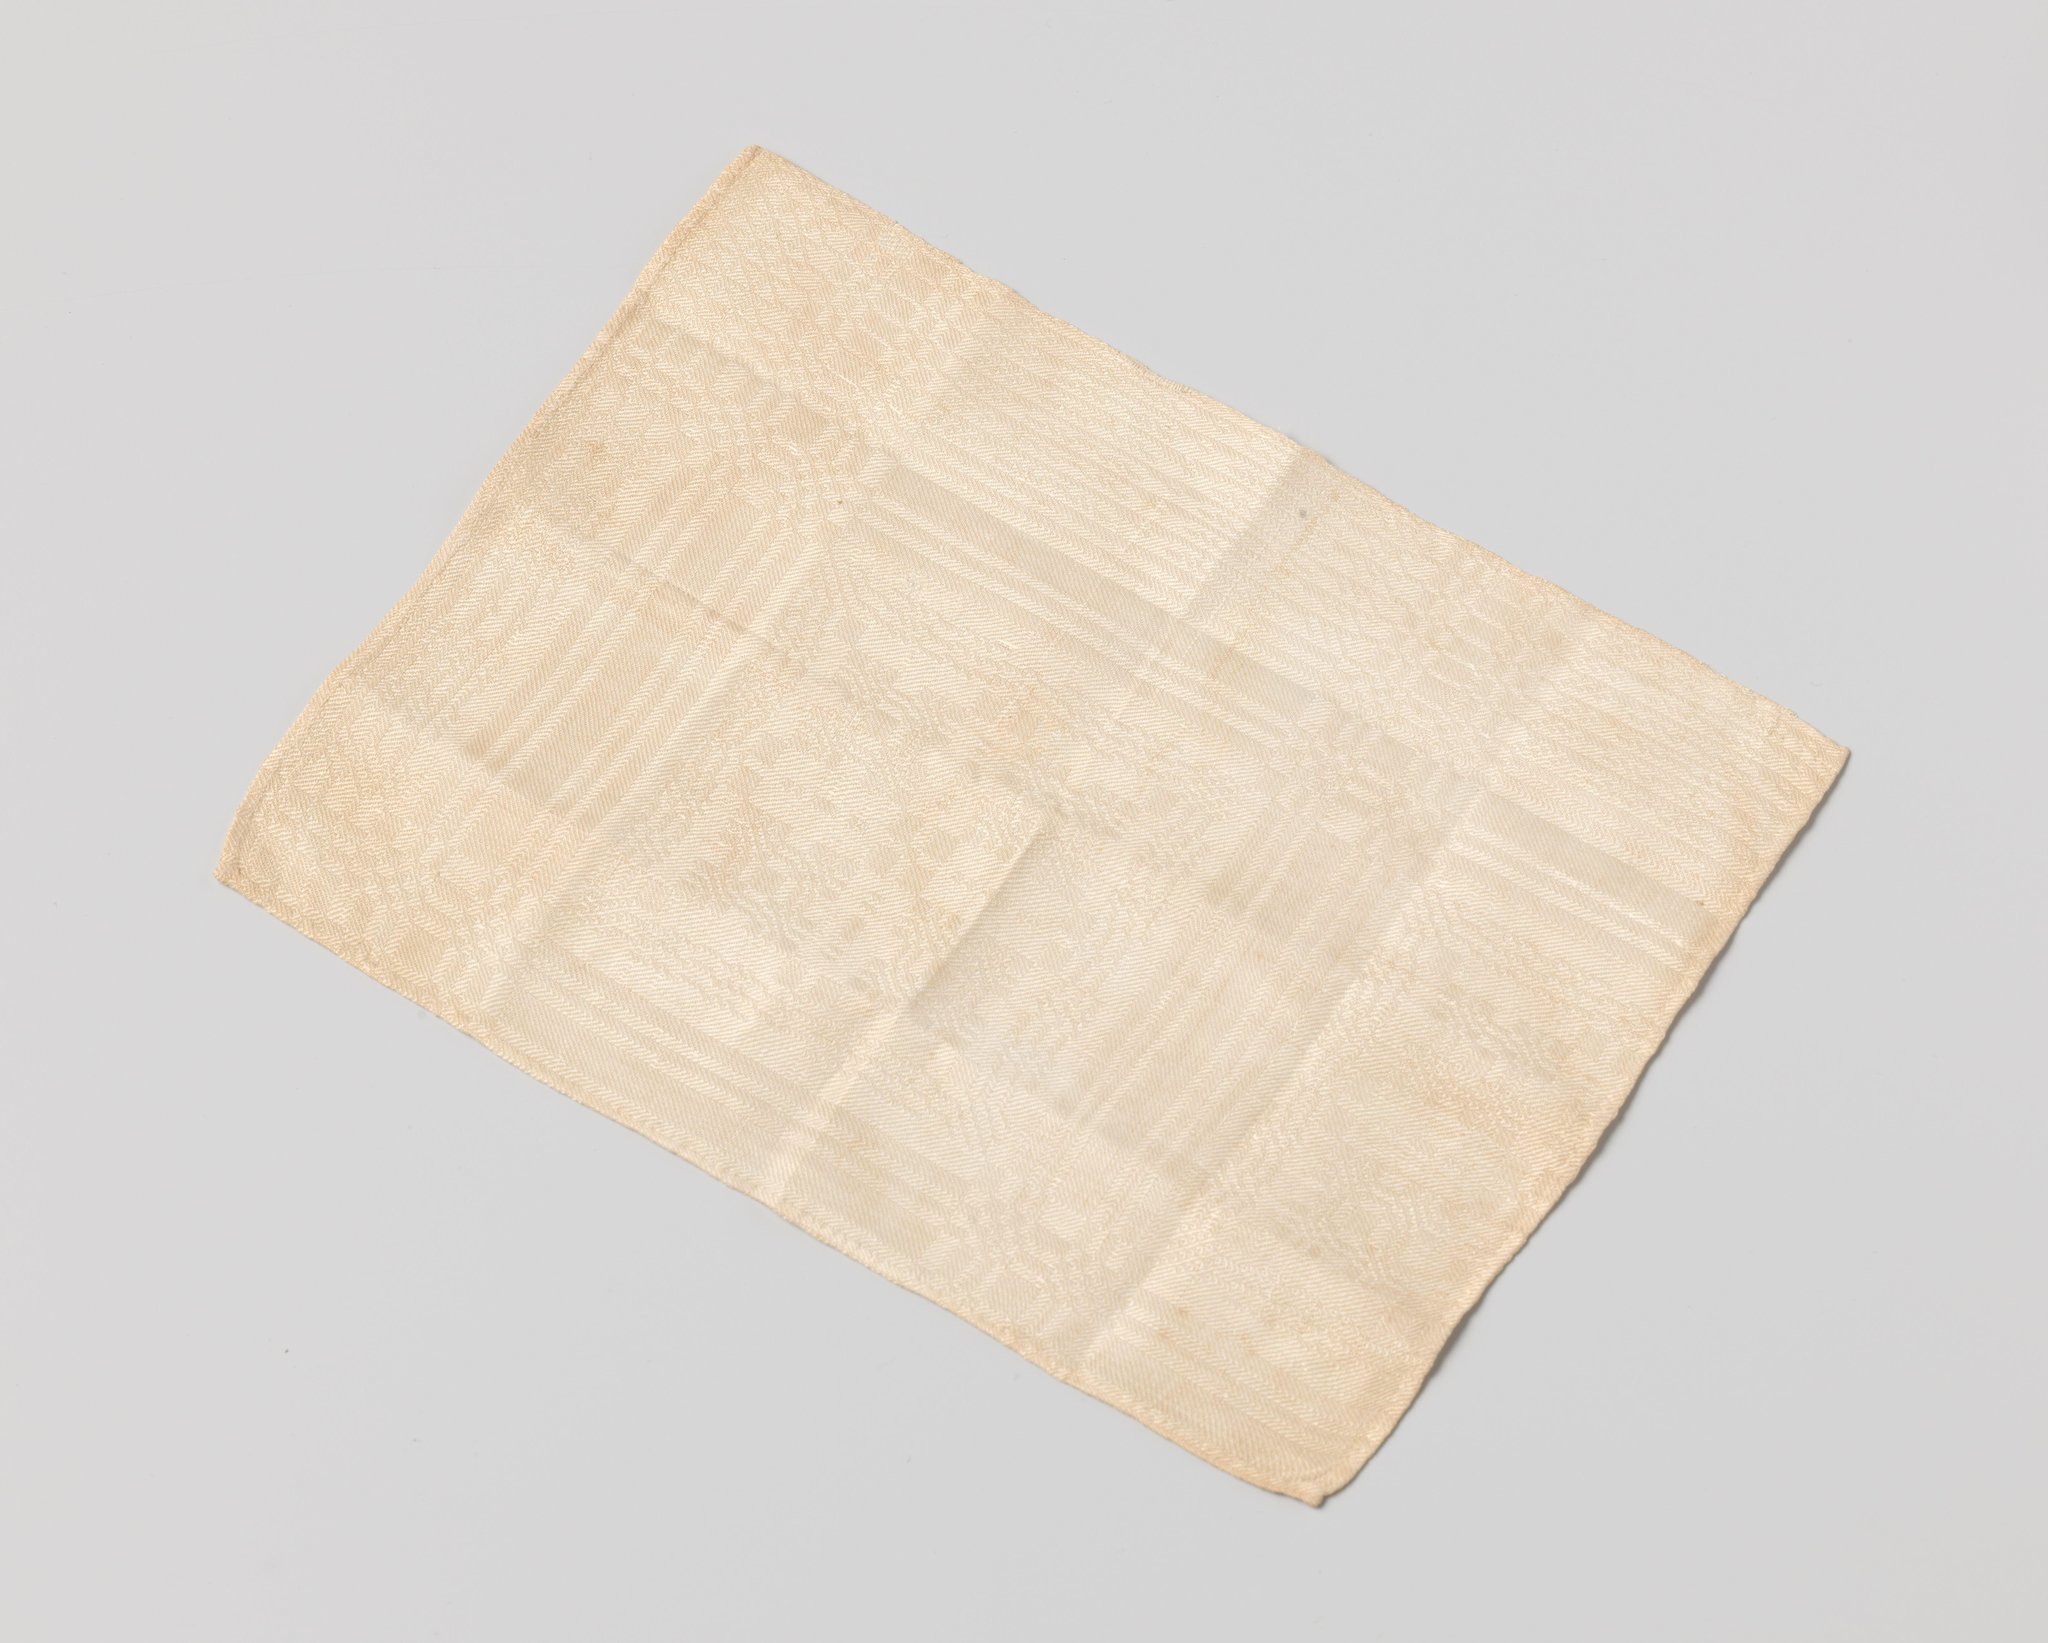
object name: miniature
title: Tafellaken Grachtenhuis, met ingeweven pellenpatroon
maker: Anonymous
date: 1750-1800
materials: linen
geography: netherlands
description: Tafelkleed Grachtenhuis, van linnen met pellenpatroon, geknipt uit grotere lap; aan drie zijden omzoomd met een zelfkant.